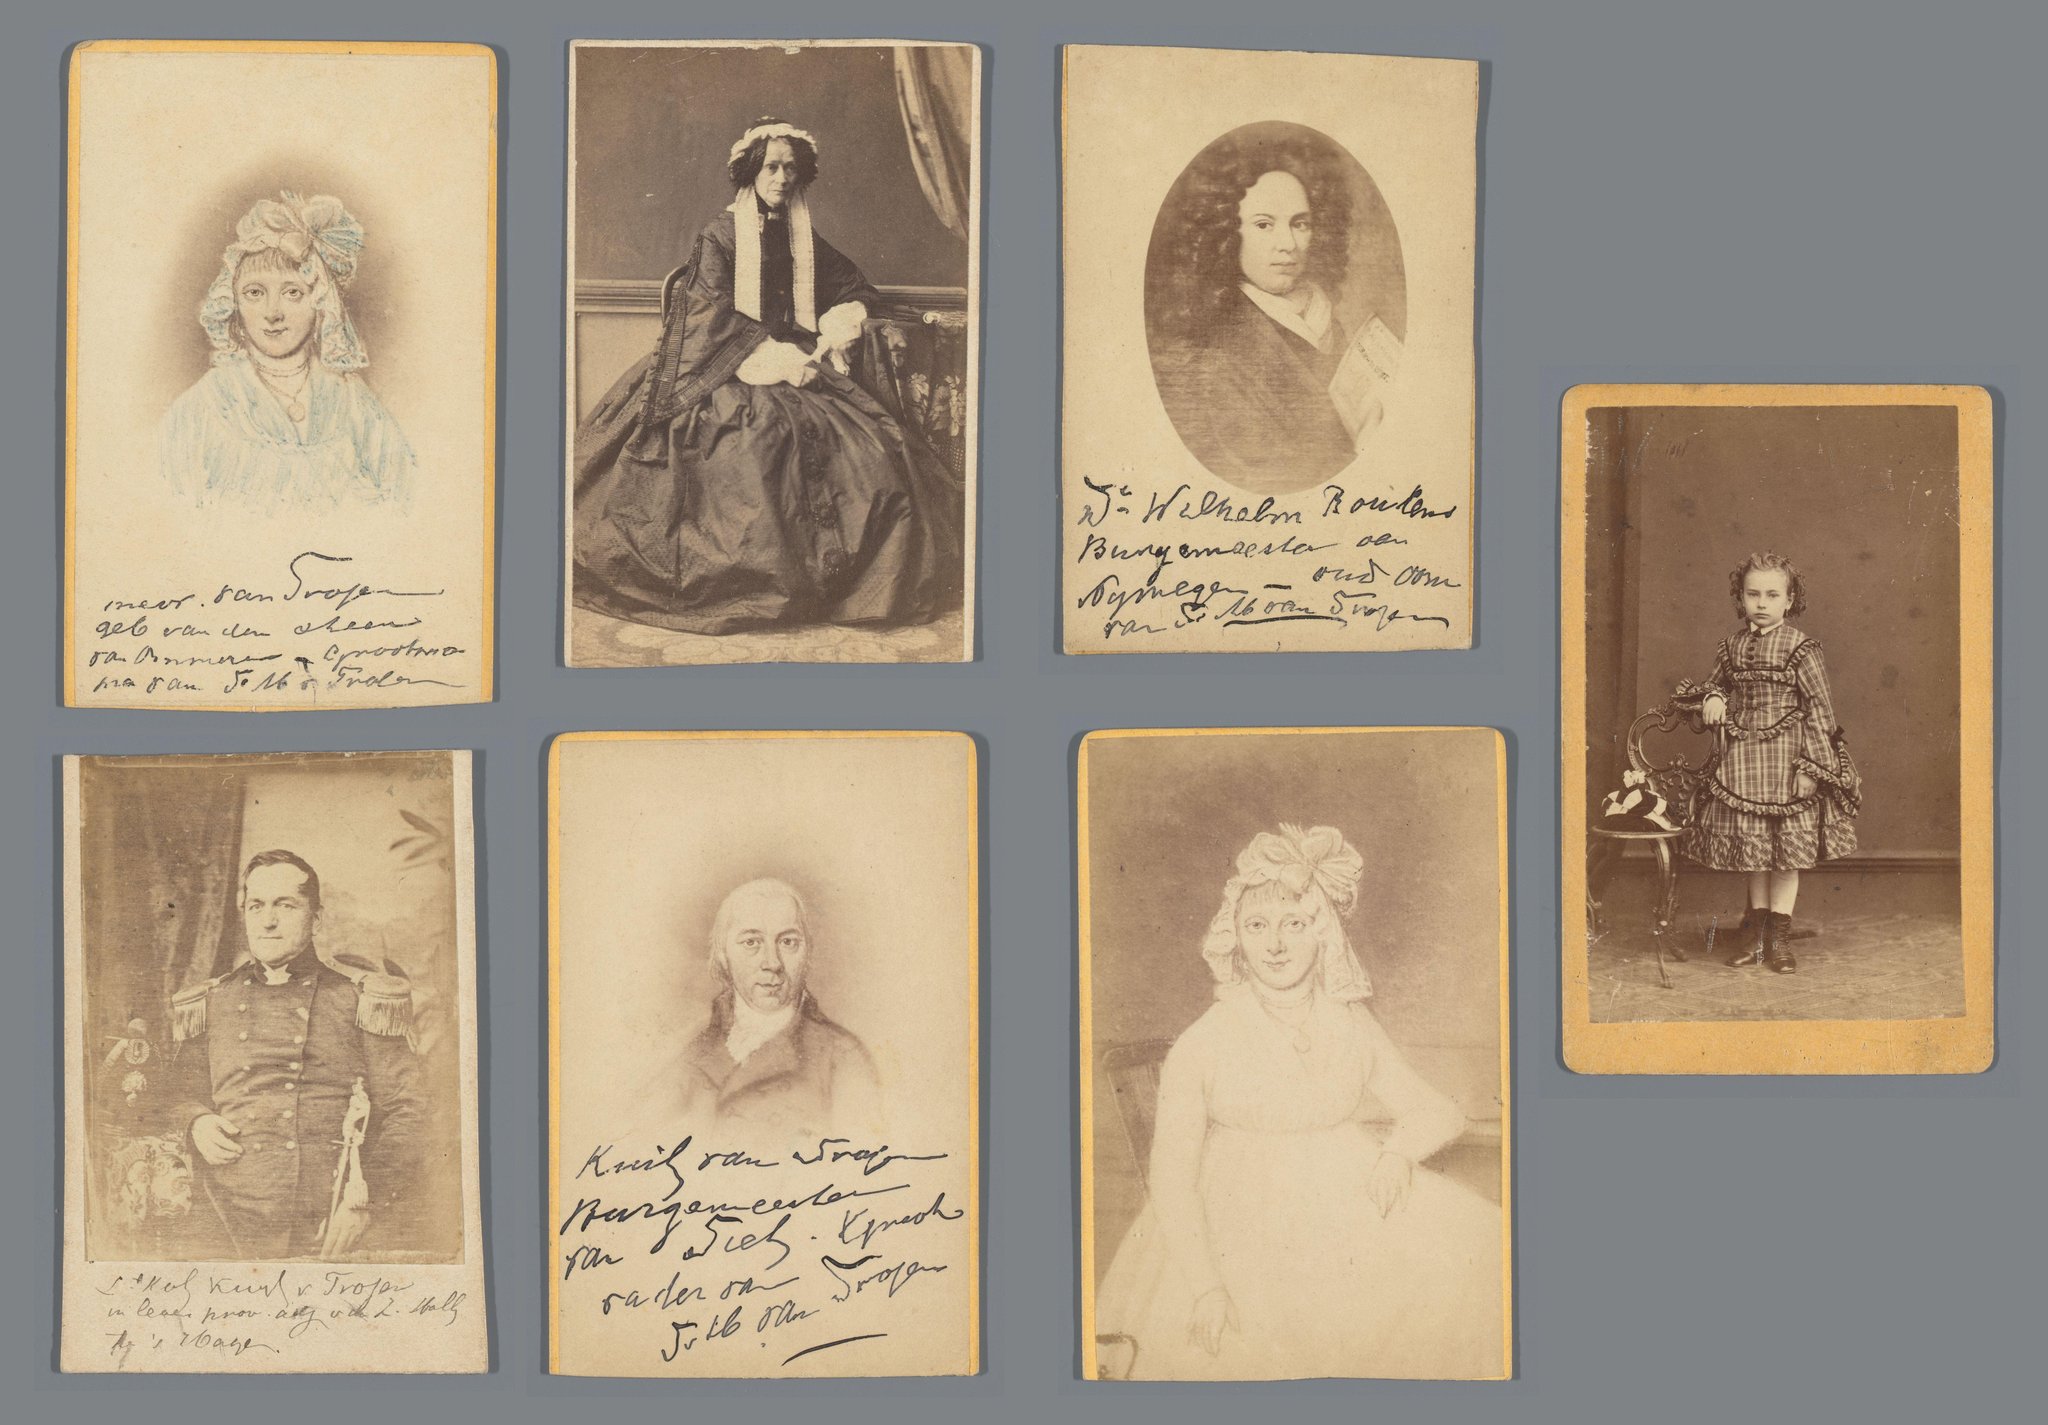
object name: photograph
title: Foto's van de voorouders van Z. van Troyen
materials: cardboard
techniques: photography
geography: the hague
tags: troyen, familie van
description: Zeven foto's (van de voorouders van Z. van Troyen).